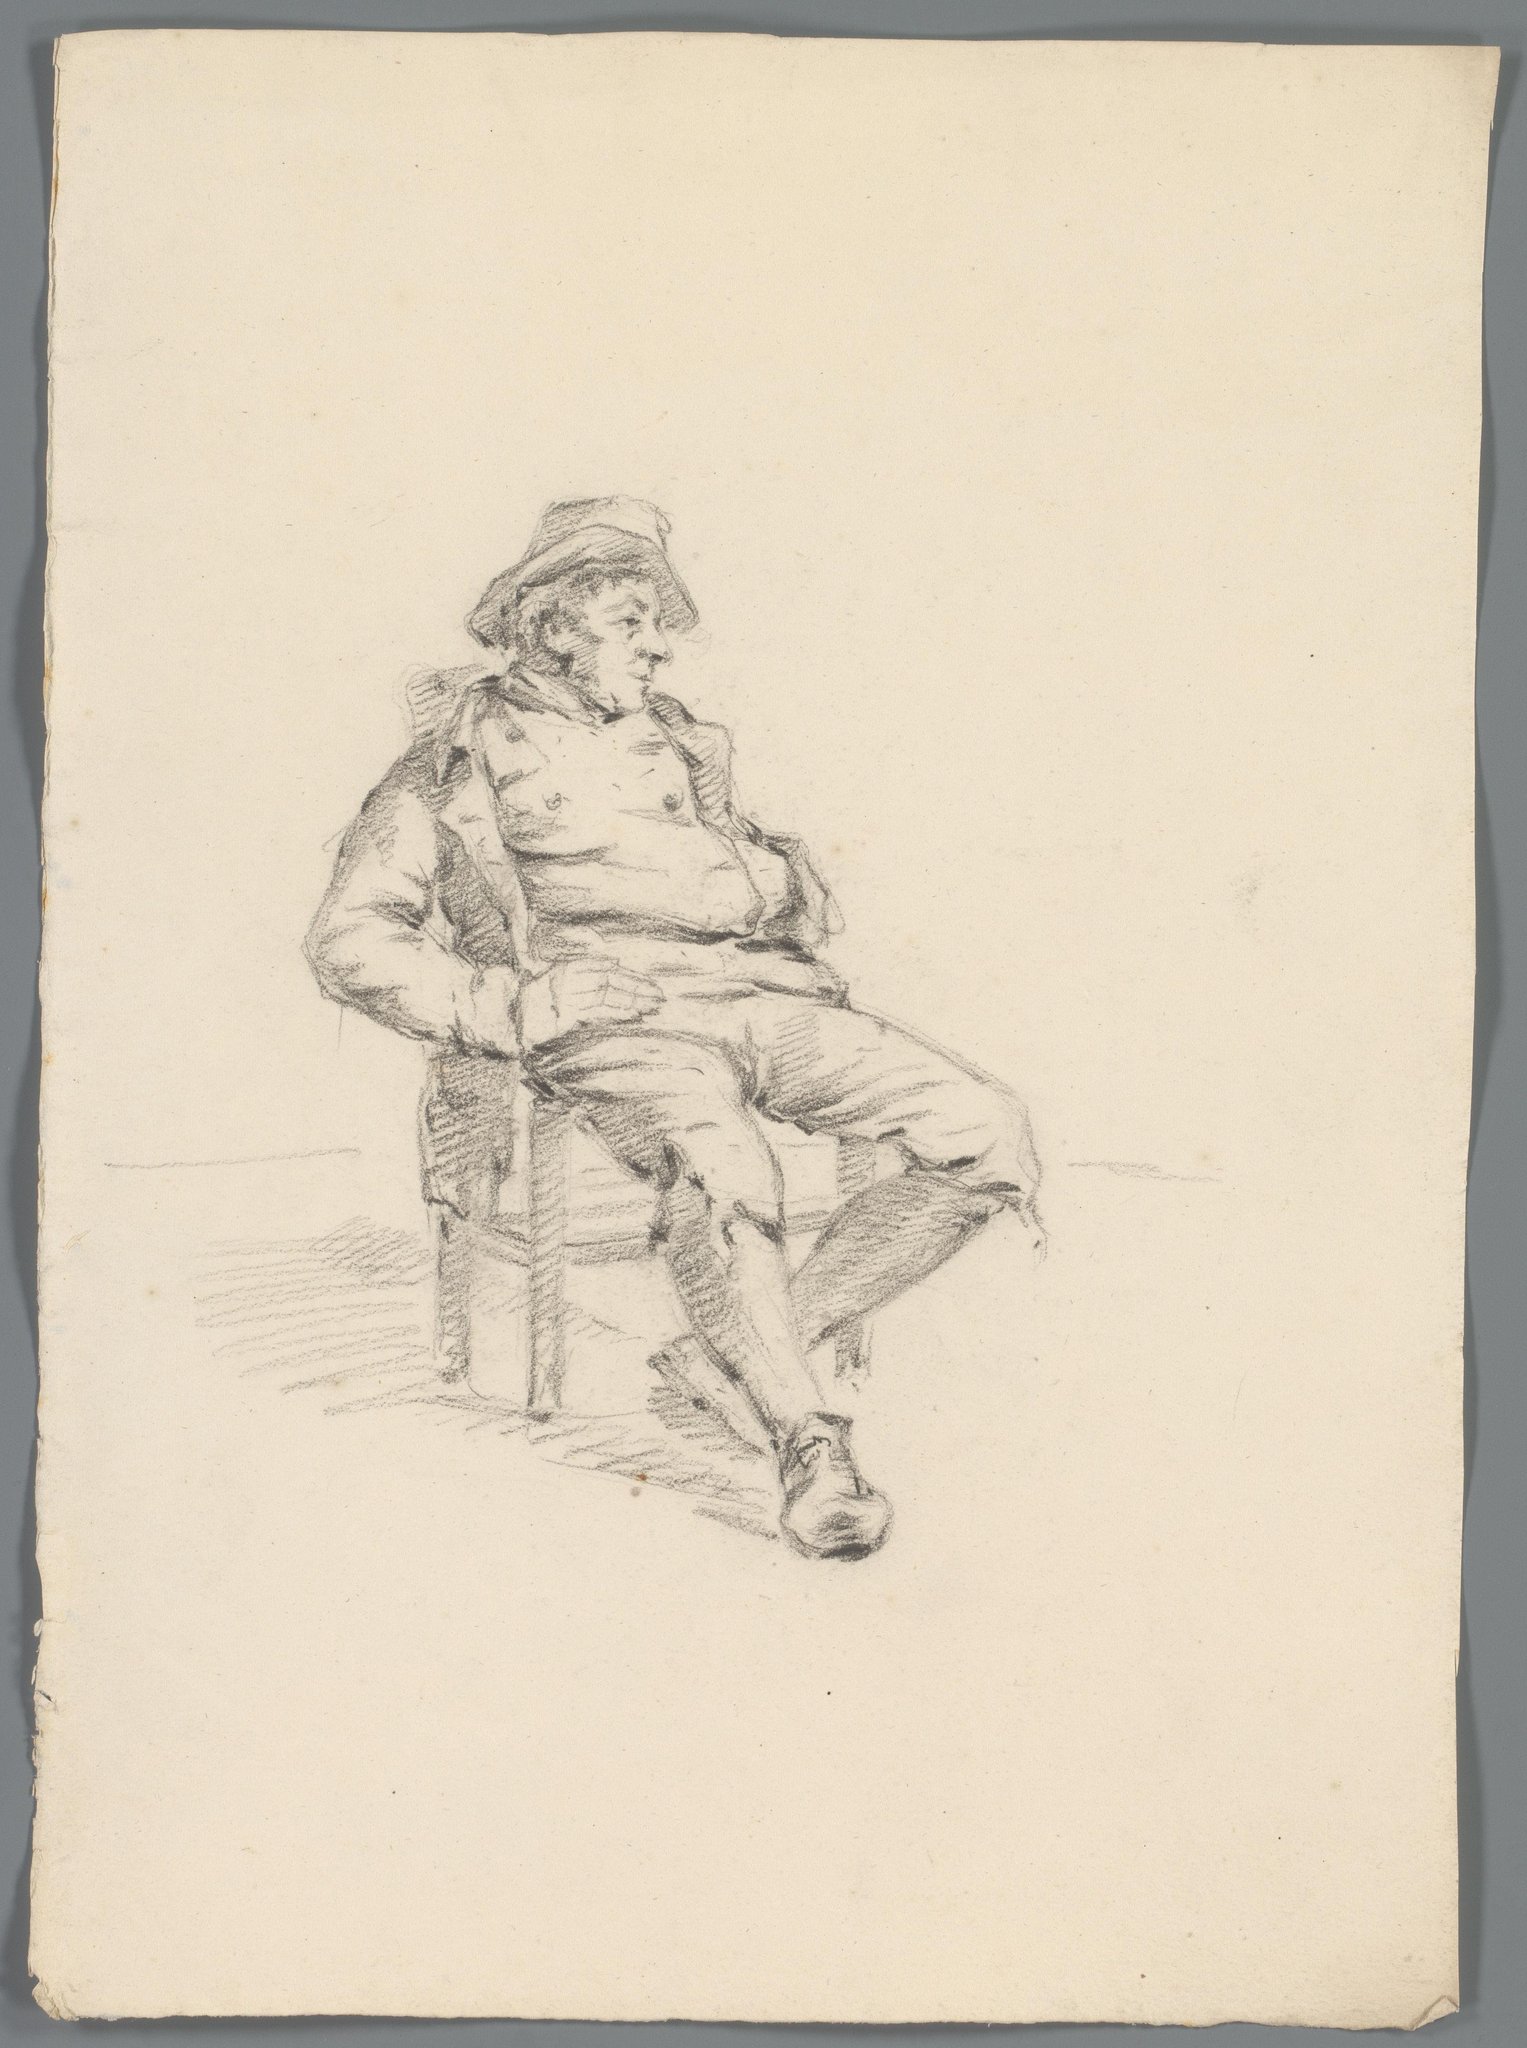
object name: drawing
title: Onderuitgezakte man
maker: Anonymous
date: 1820-1830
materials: chalk, paper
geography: the hague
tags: sitting figure, adult man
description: Tekeningen waarschijnlijk ontstaan bij het Haagse kunstgenootschap ‘Tot Nut der Tekenkunst’, waar twee keer per week tekenavonden werden georganiseerd met geklede modellen.